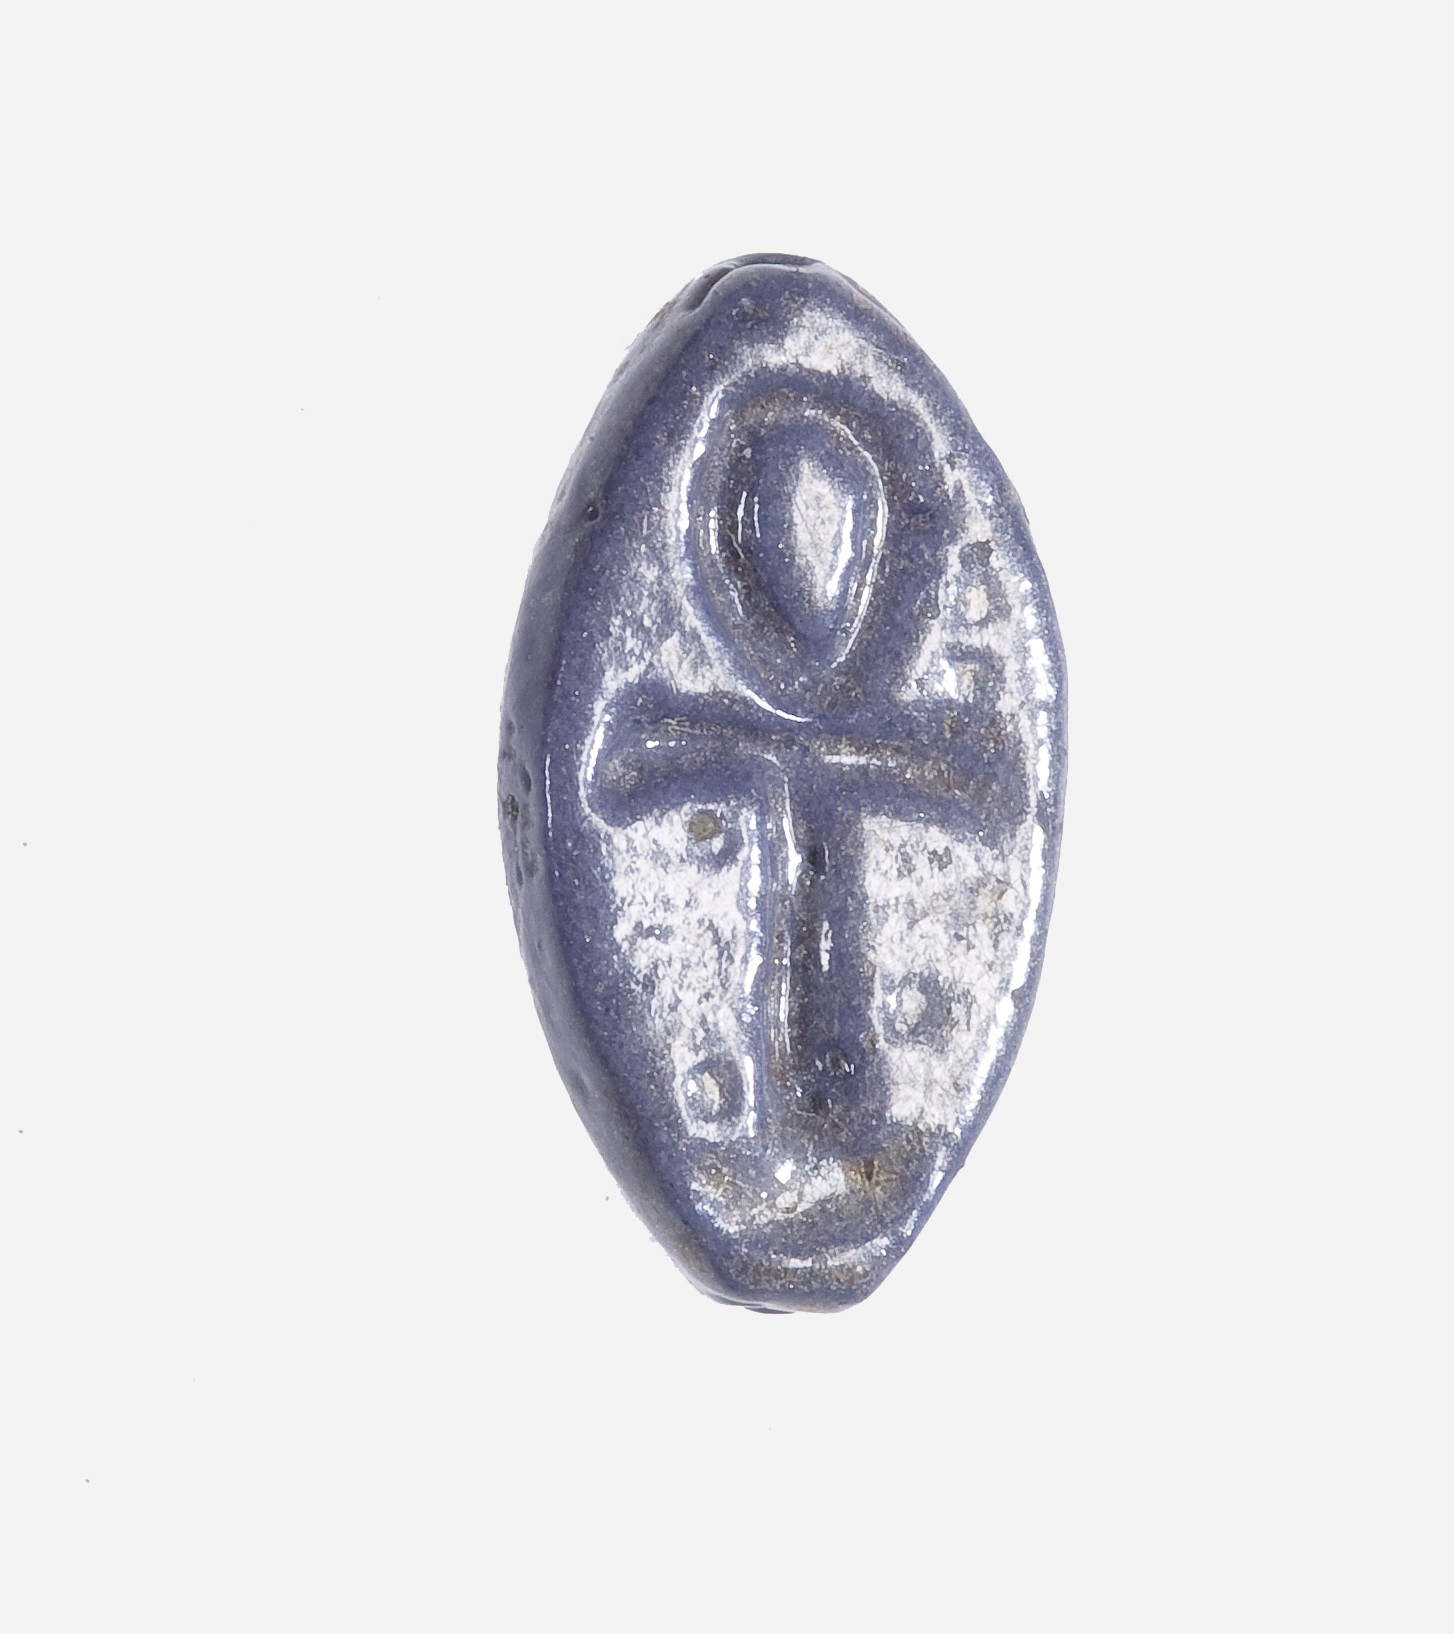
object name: cowroid seal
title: Cowroid Stamp Seal with an Ankh Inscribed on the Base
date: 1390-1352 BCE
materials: faience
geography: egypt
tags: hieroglyphs